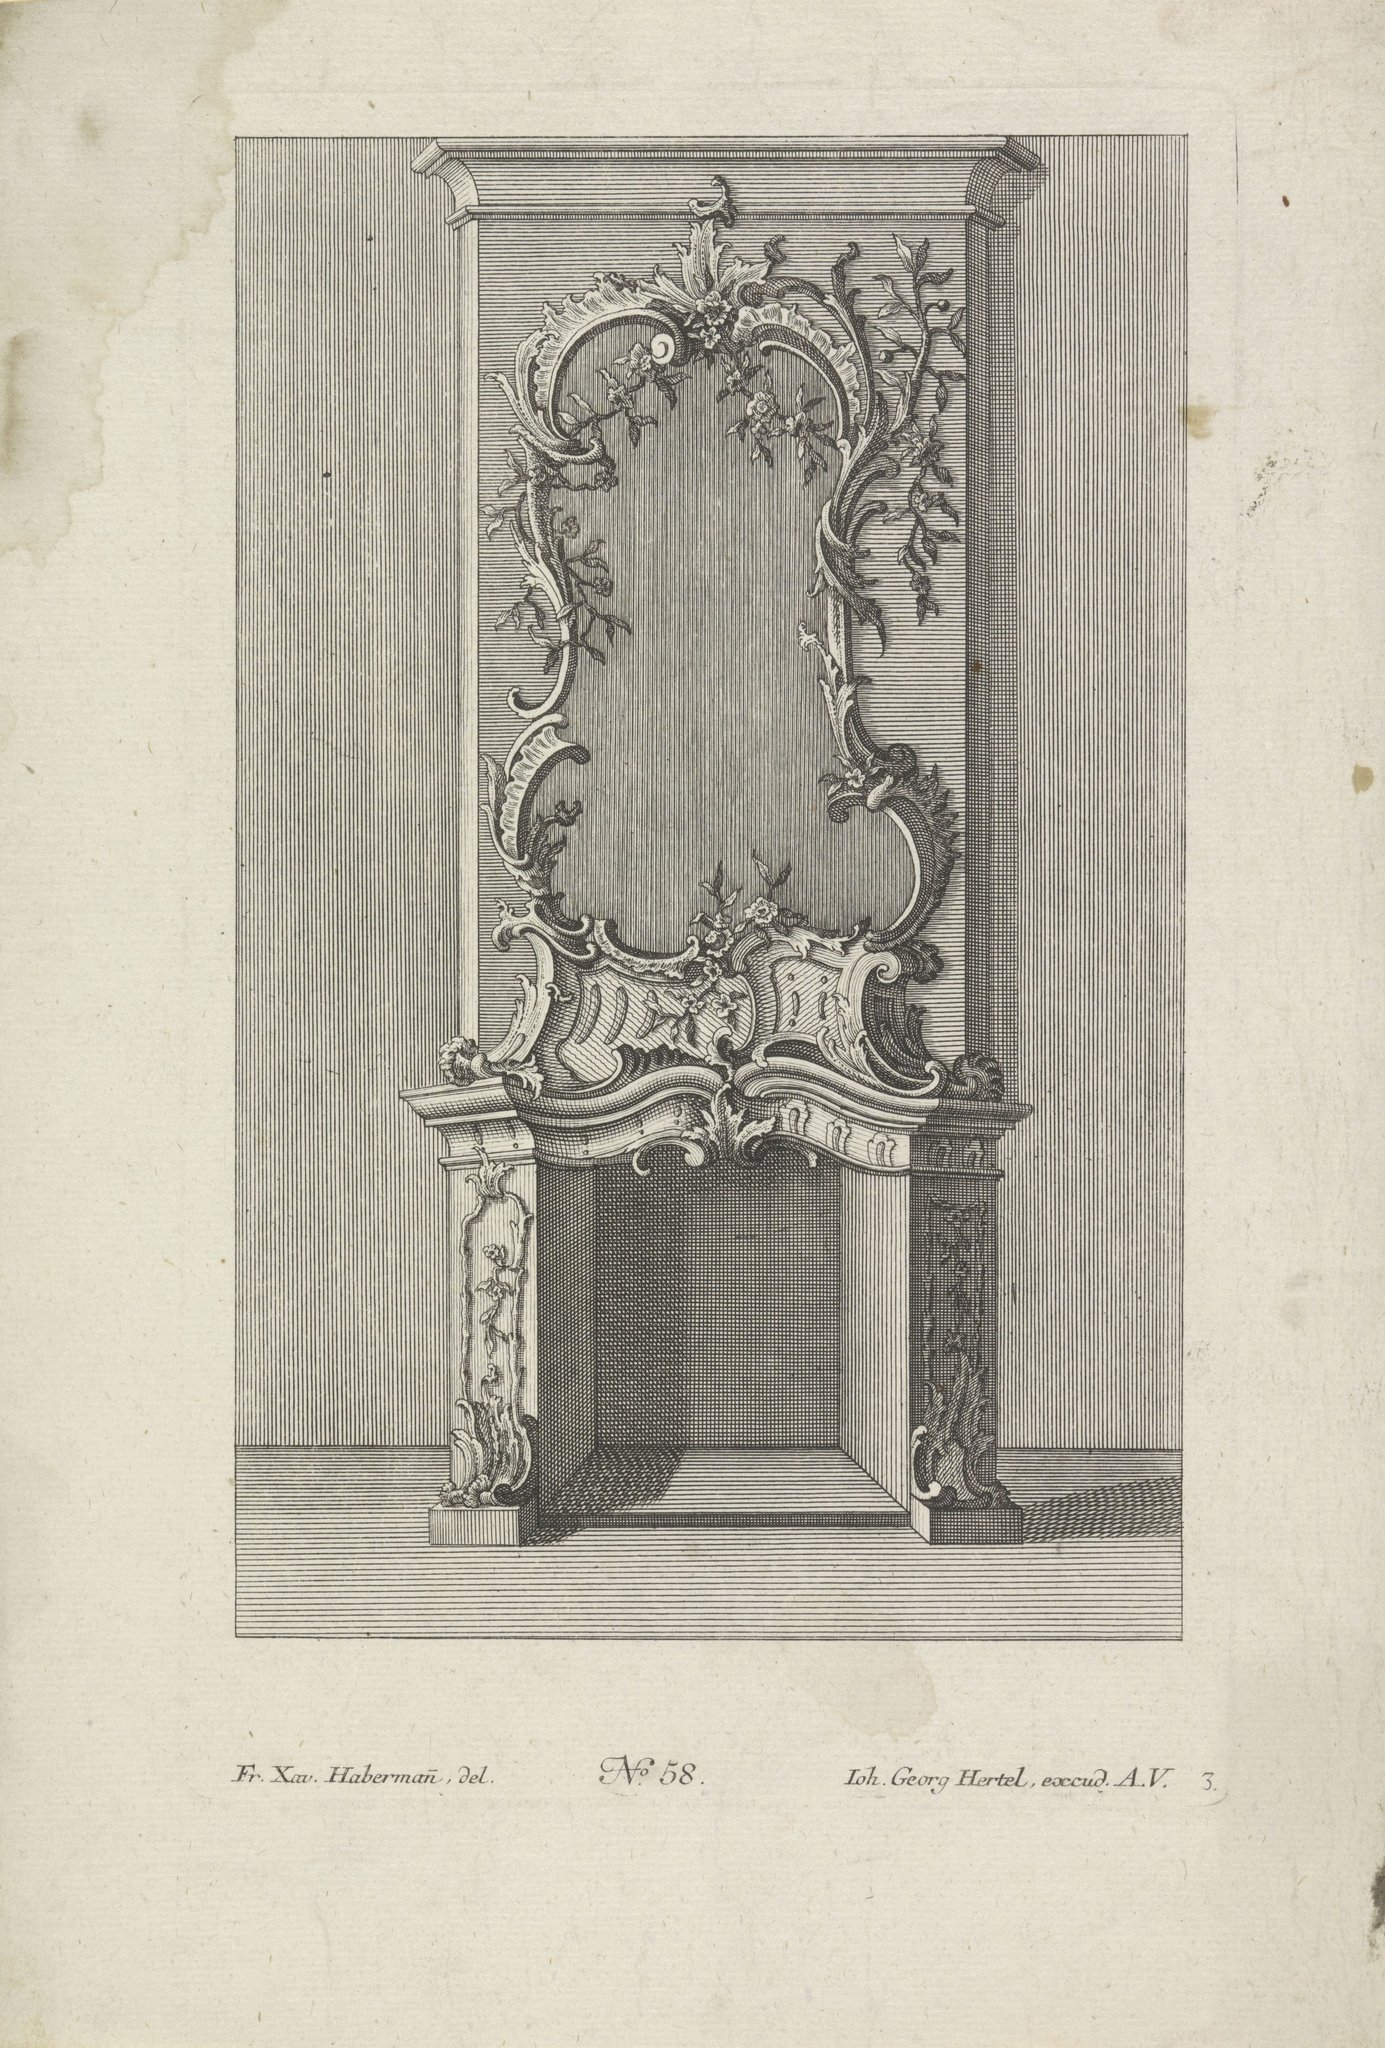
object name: ornament print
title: Schouw met cartouche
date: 1731-1775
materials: paper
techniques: engraving, etching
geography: augsburg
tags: rocaille ornament, open hearth, fire-place, ornament ~ cartouche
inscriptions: collector's mark: Lugt 2760, collector's mark: Lugt 2228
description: Rocaille schouw met cartouche. Uitgeversnummer 58.